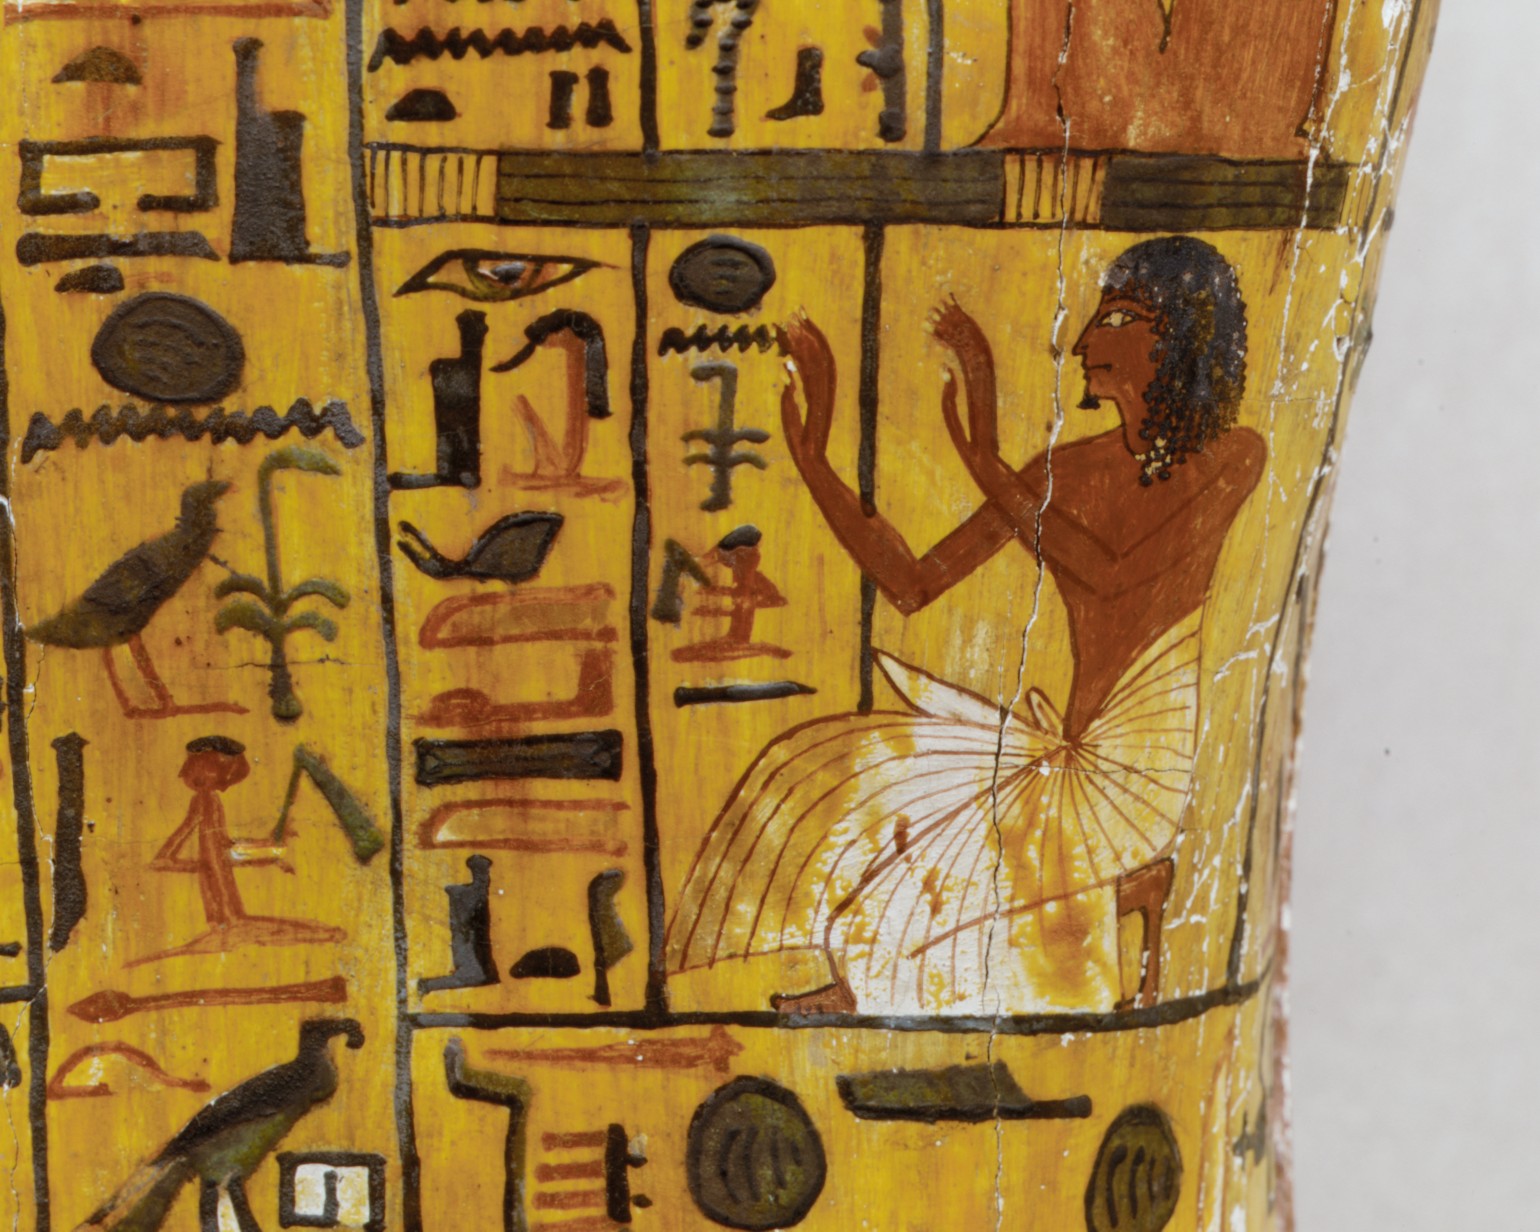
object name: coffin, khonsu, vignette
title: Vignette on Khonsu's inner coffin lid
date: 1279-1213 BCE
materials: wood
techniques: painting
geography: egypt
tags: men,hieroglyphs,coffins